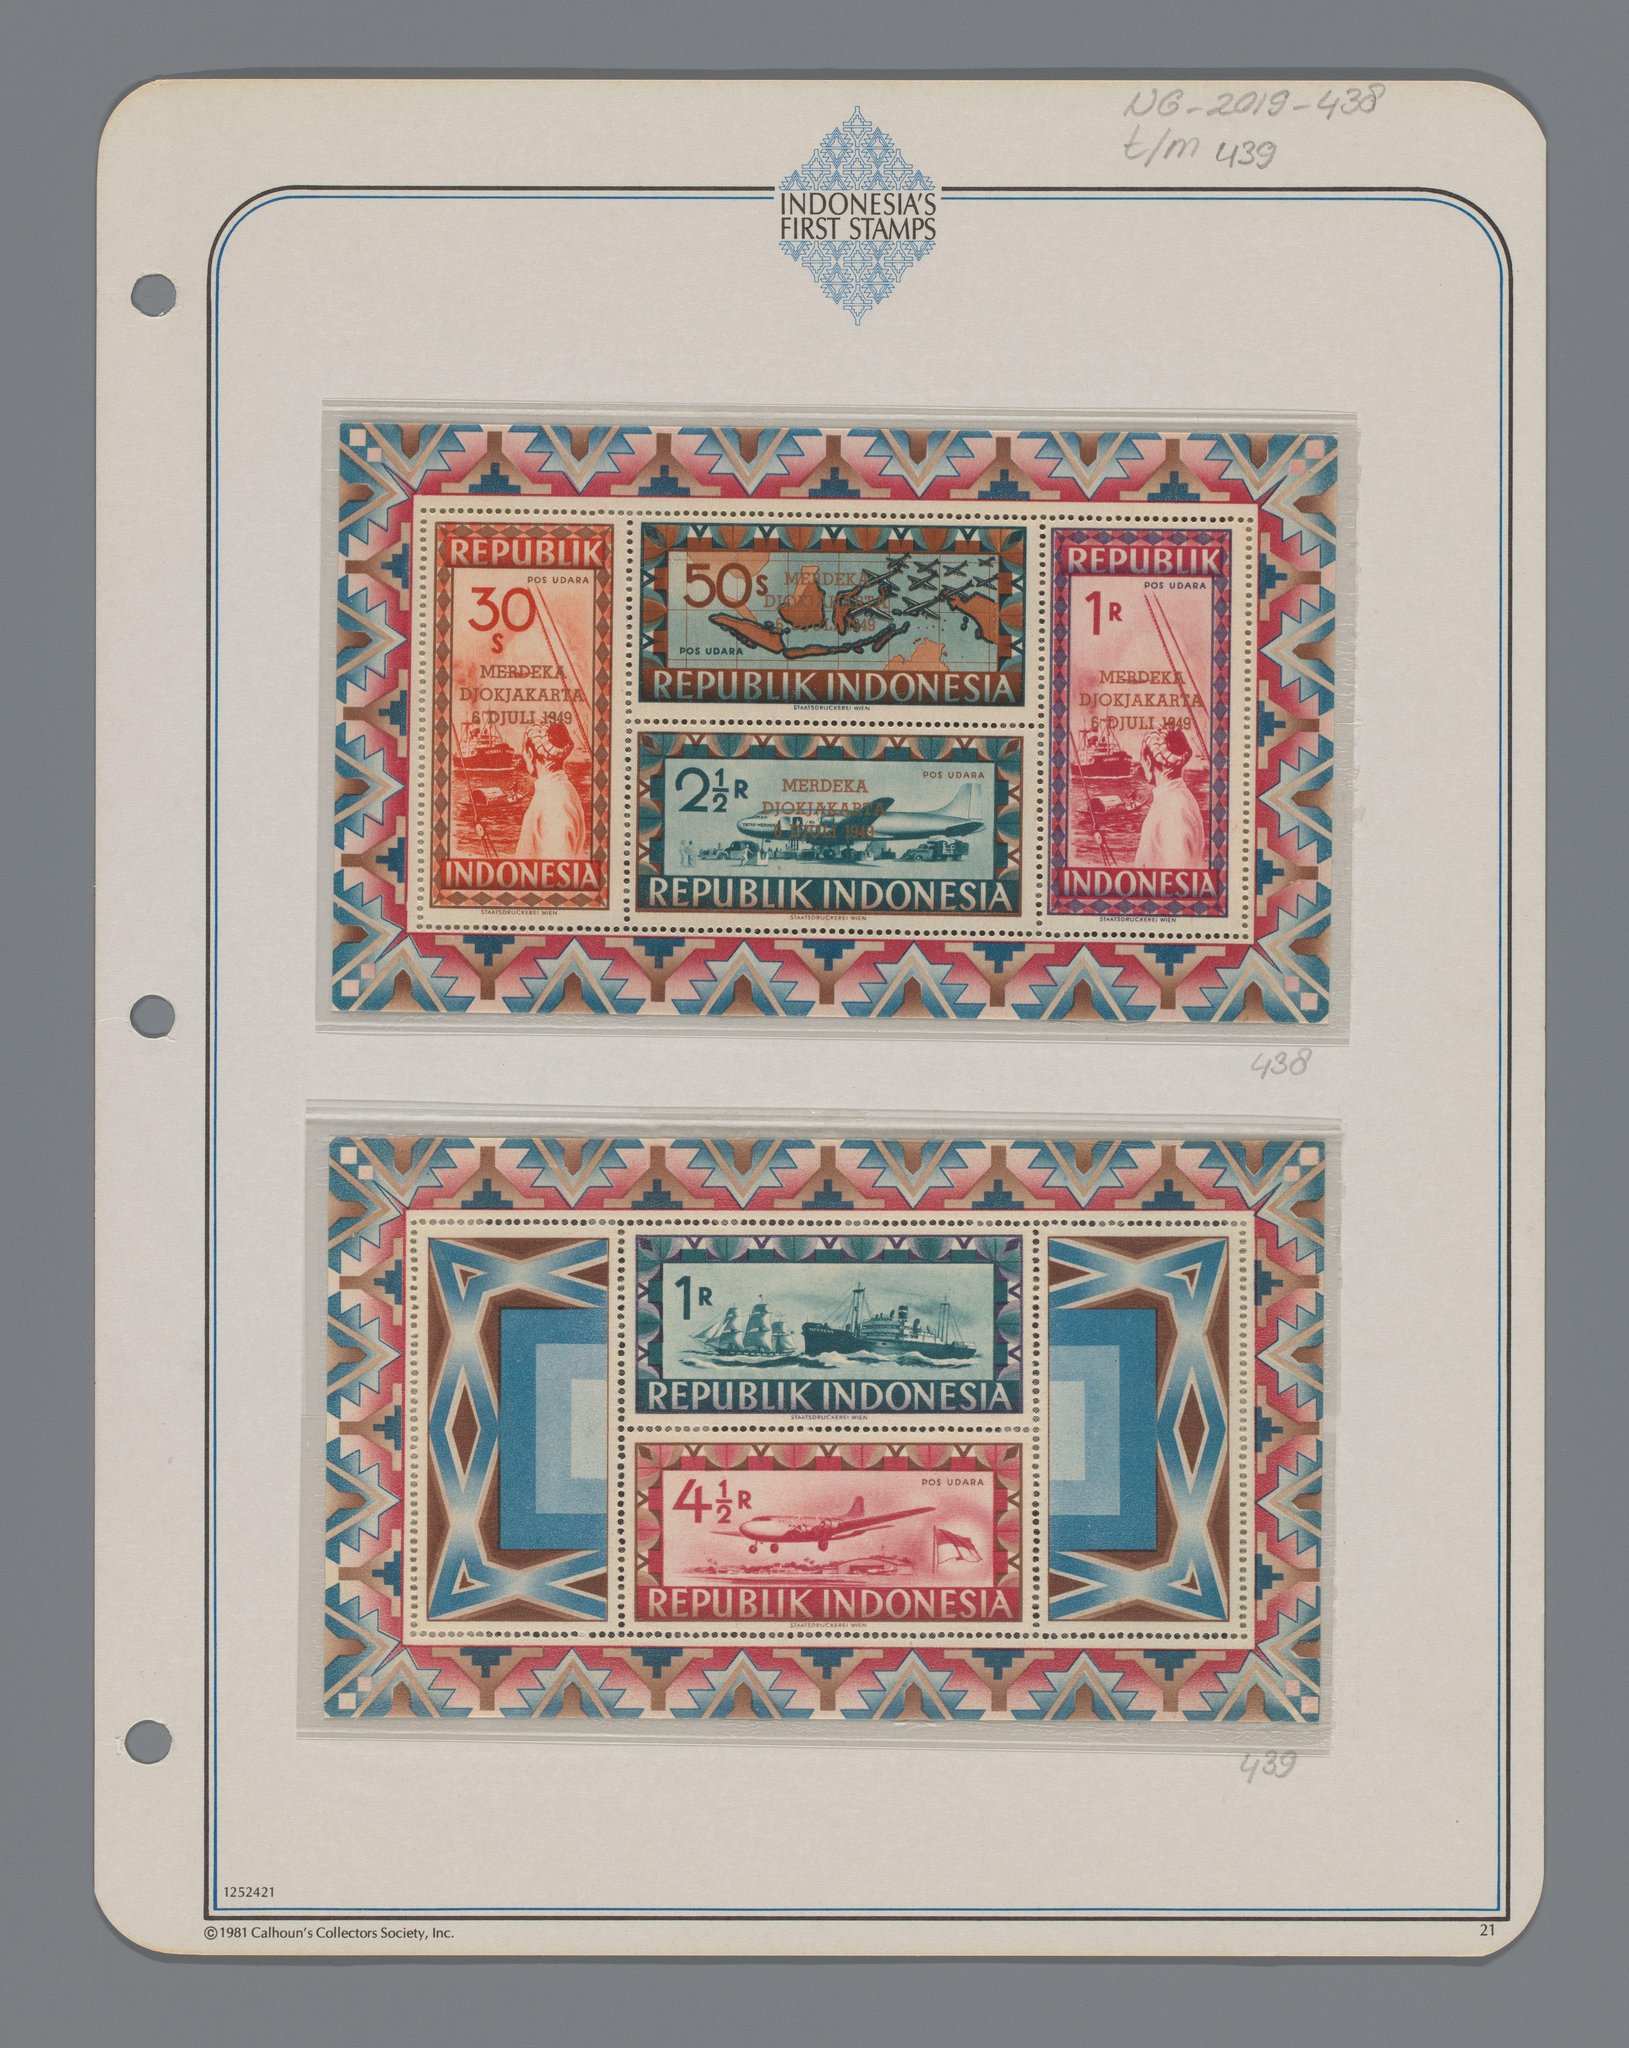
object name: postage stamp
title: Postzegel Republik Indonesia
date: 1949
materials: paper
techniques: photoaquatint, engraving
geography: vienna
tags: indonesia